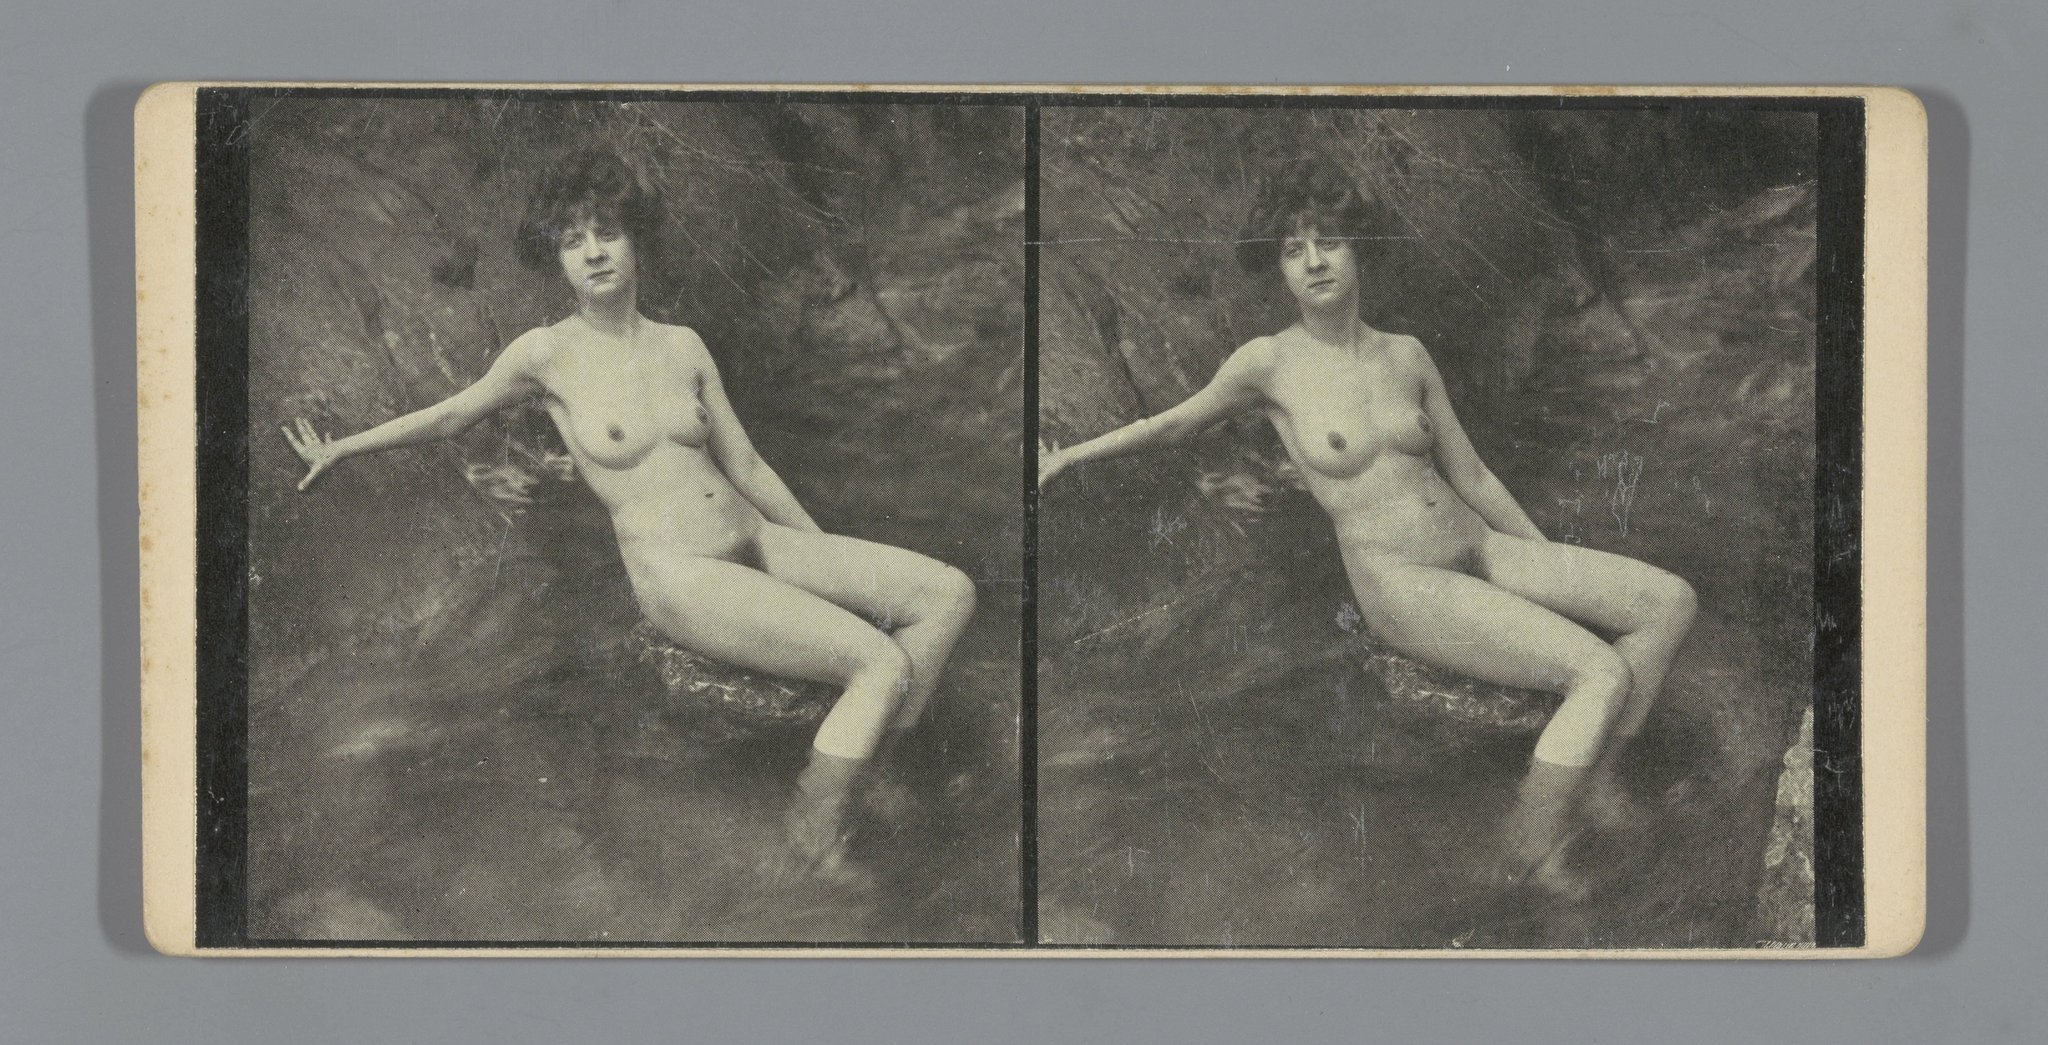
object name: stereograph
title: Portret van een naakte vrouw in de natuur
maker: Anonymous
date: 1873-1910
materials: cardboard, paper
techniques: autotype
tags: woman (showing herself) undressed, quasi-nude, anonymous historical person portrayed